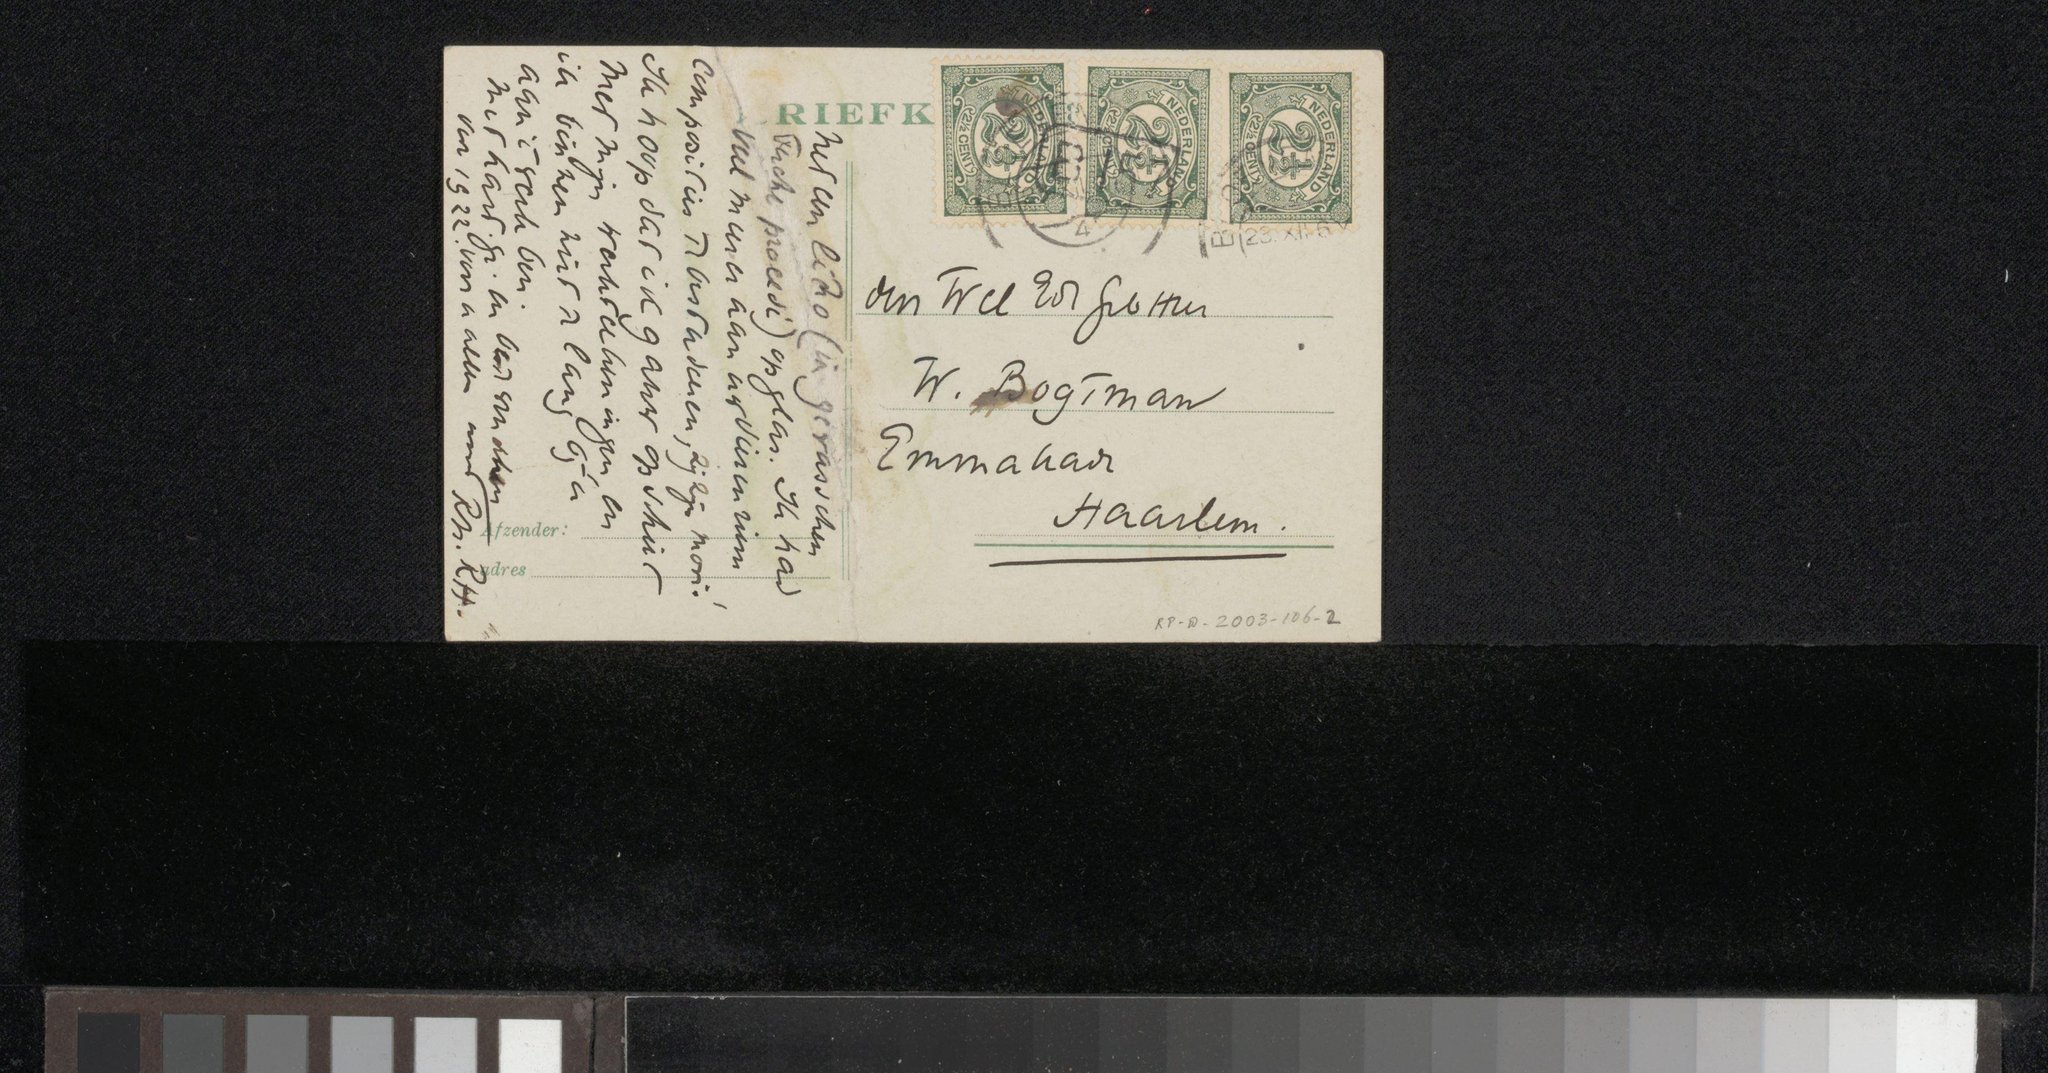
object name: postcard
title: Briefkaart aan Willem Bogtman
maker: richard nicolaüs roland holst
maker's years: 1868-1938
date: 1921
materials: cardboard, ink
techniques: pen, writing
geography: buissche heide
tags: willem bogtman, drawing, applied arts, arts and crafts; industrial design, the graphic arts, diseases